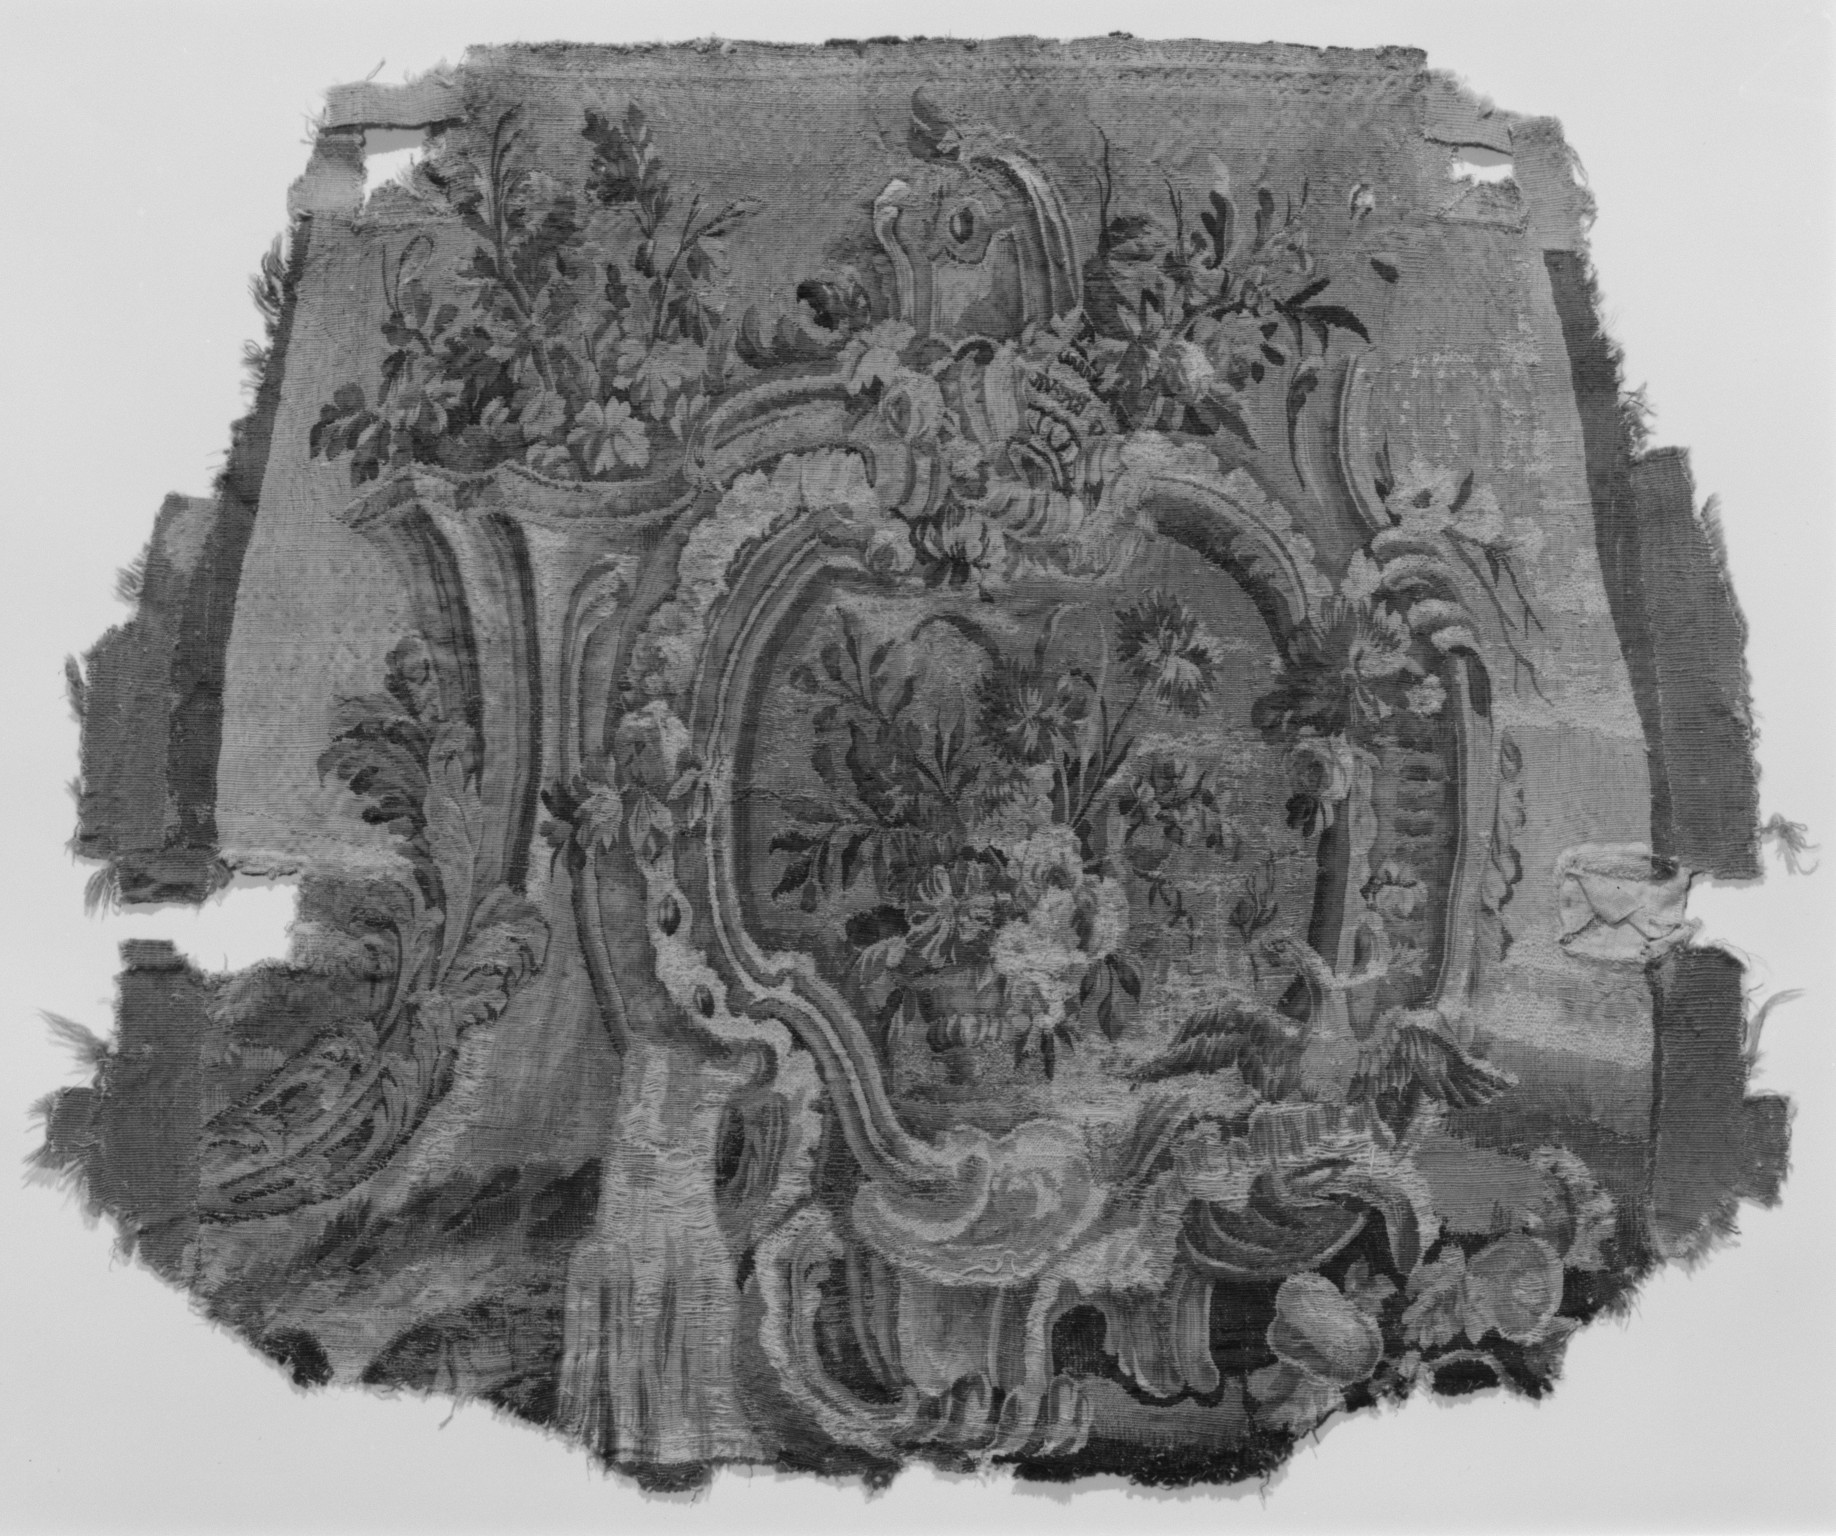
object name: upholstery panel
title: Rocaille cartouches with flowers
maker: pierre edmé babel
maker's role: designer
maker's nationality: french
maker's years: 1720-1775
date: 1735-1750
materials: silk, wool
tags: flowers